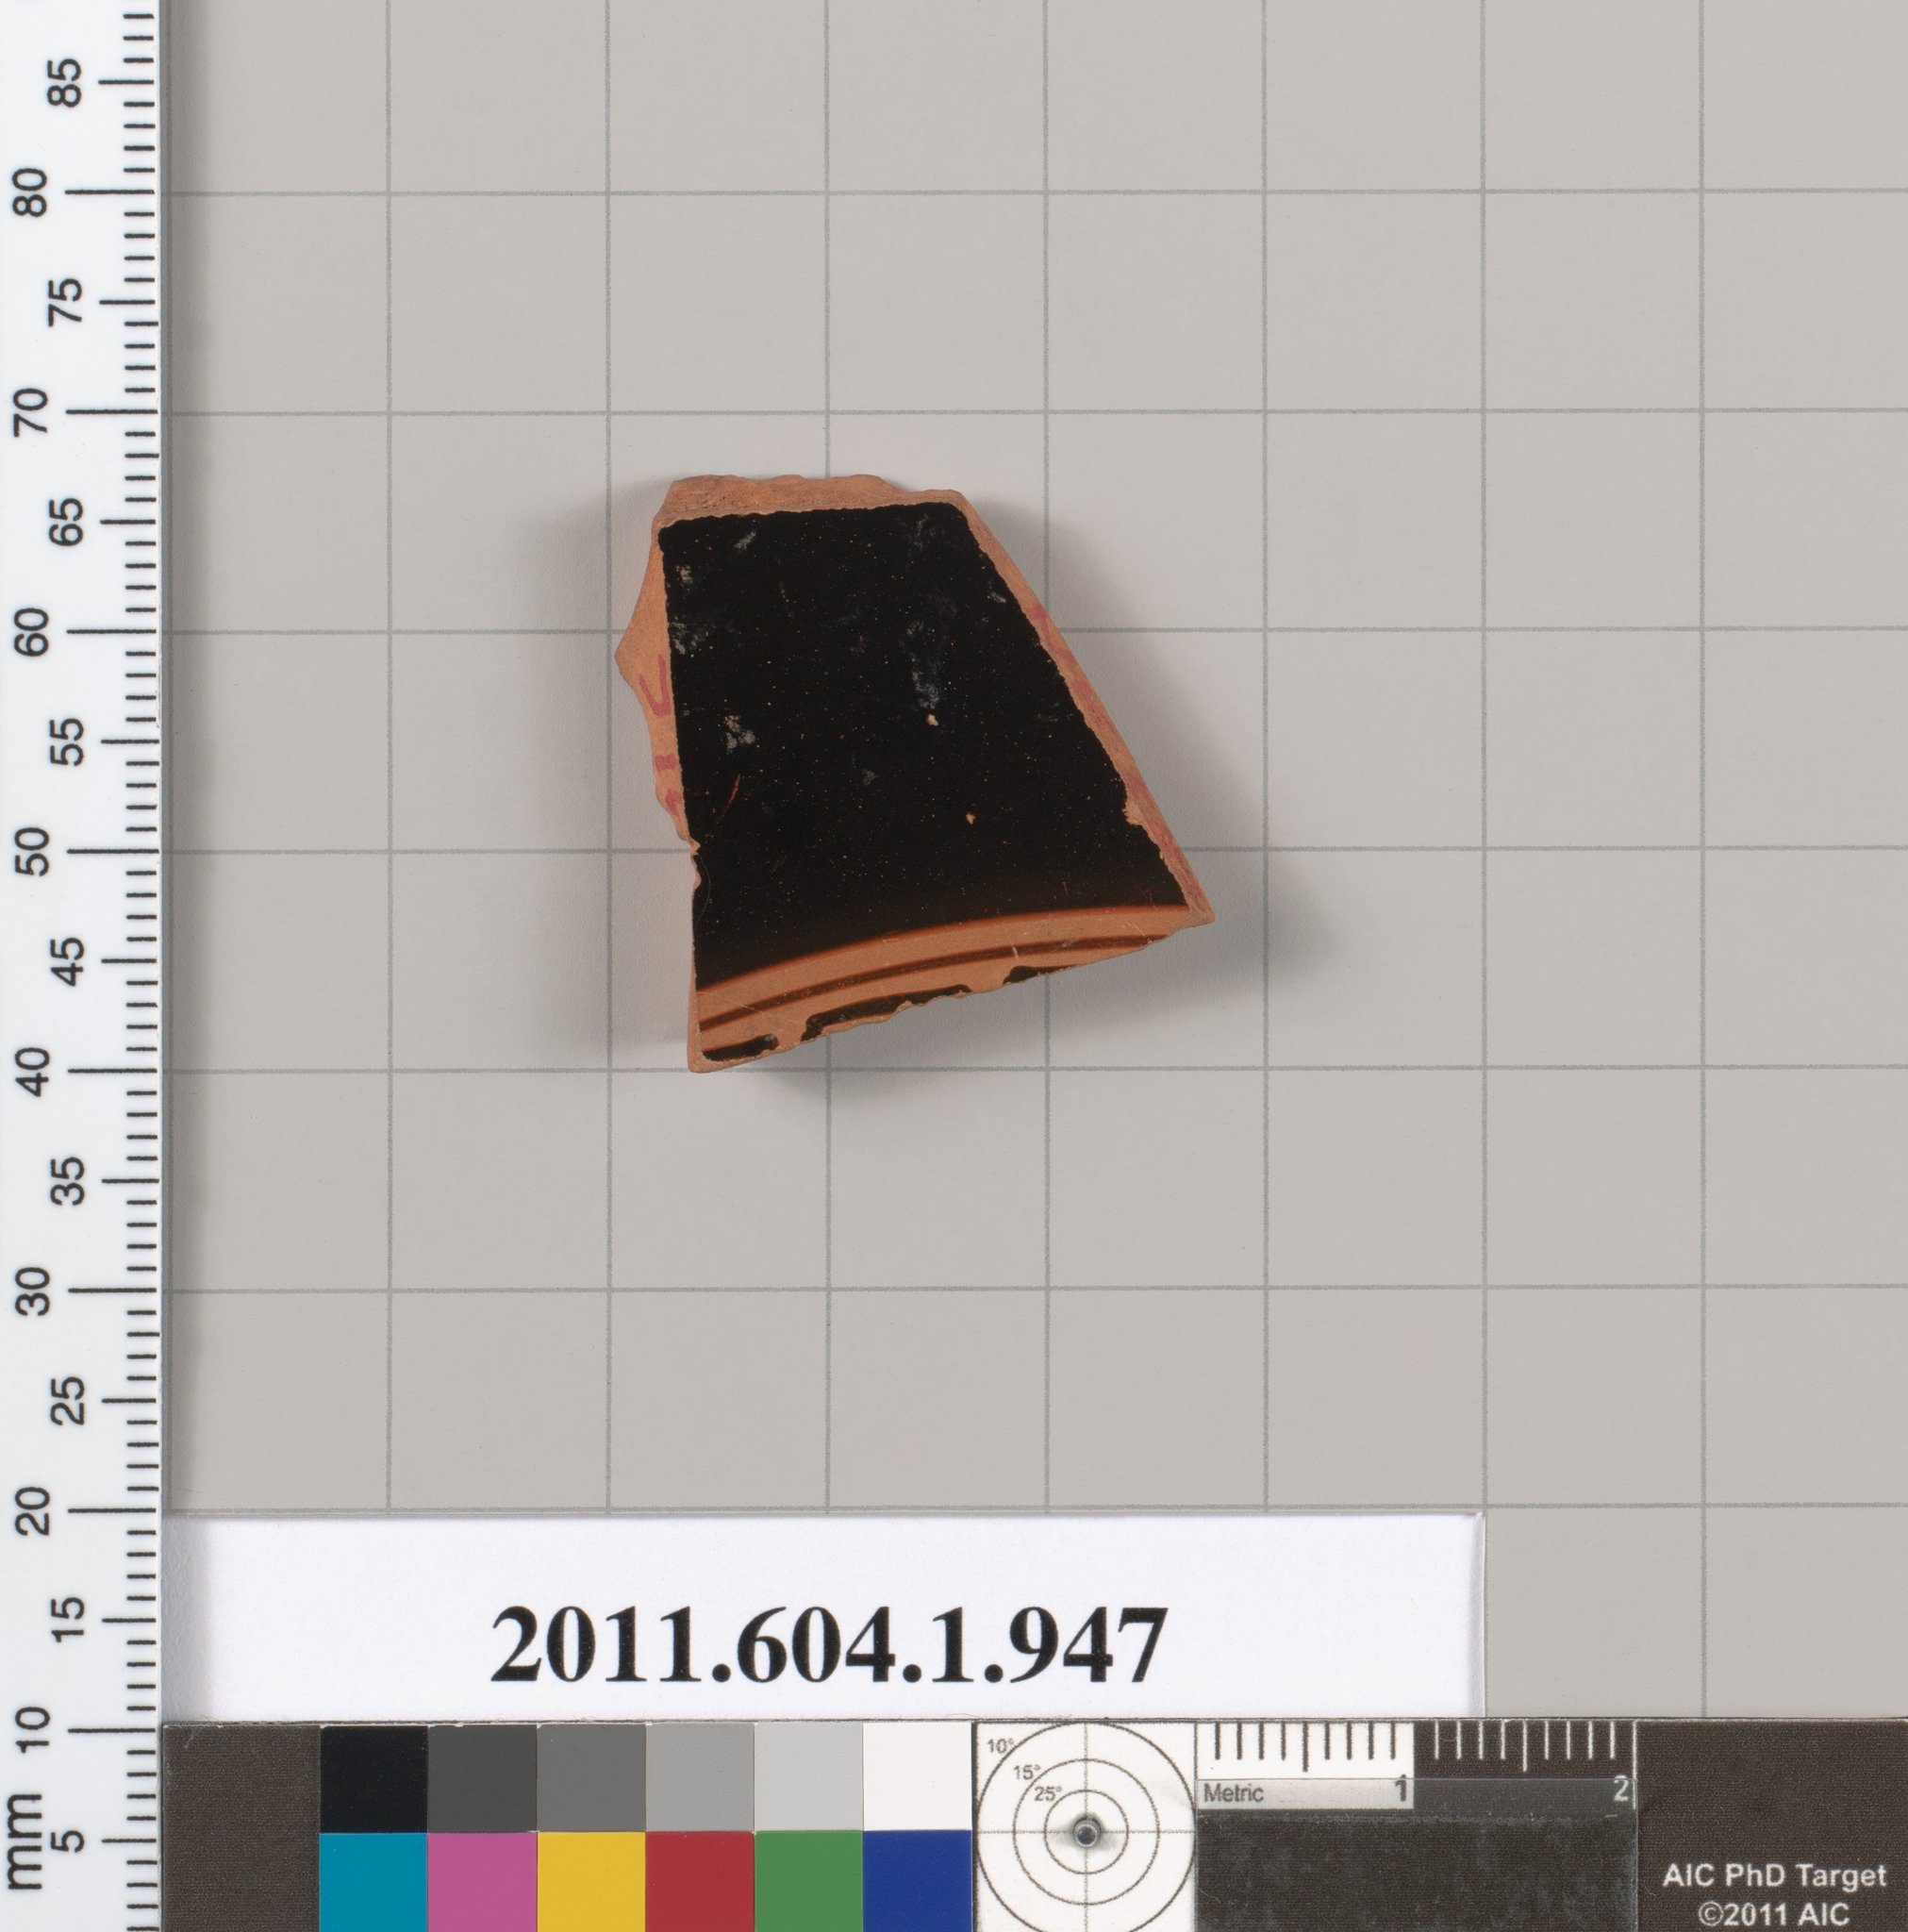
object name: kylix fragment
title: Terracotta fragment of a kylix (drinking cup)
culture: greek, attic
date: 490-480 BCE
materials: terracotta